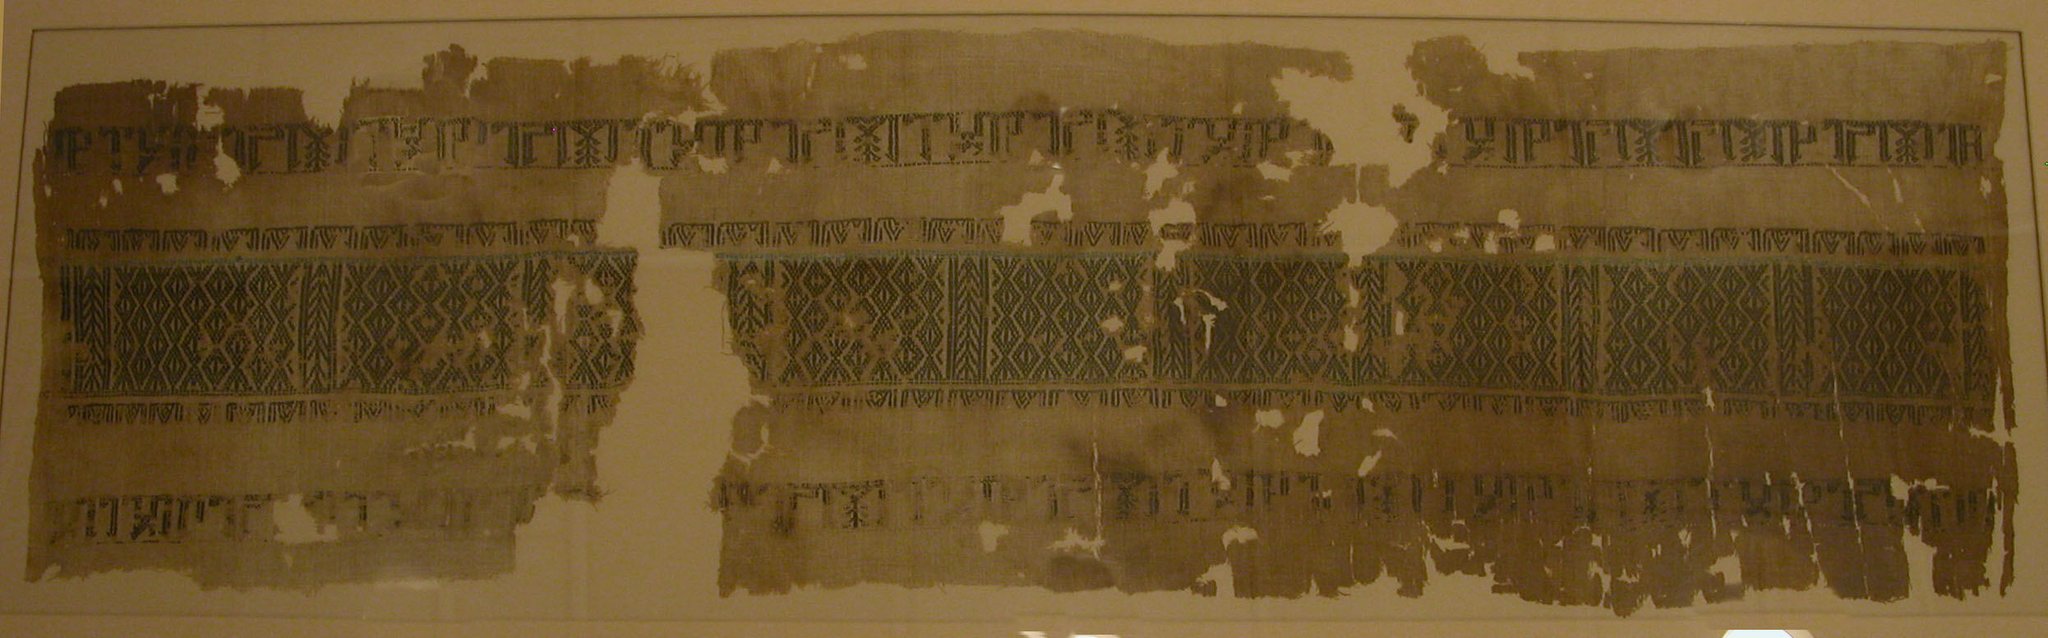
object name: strip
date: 801-900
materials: linen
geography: egypt